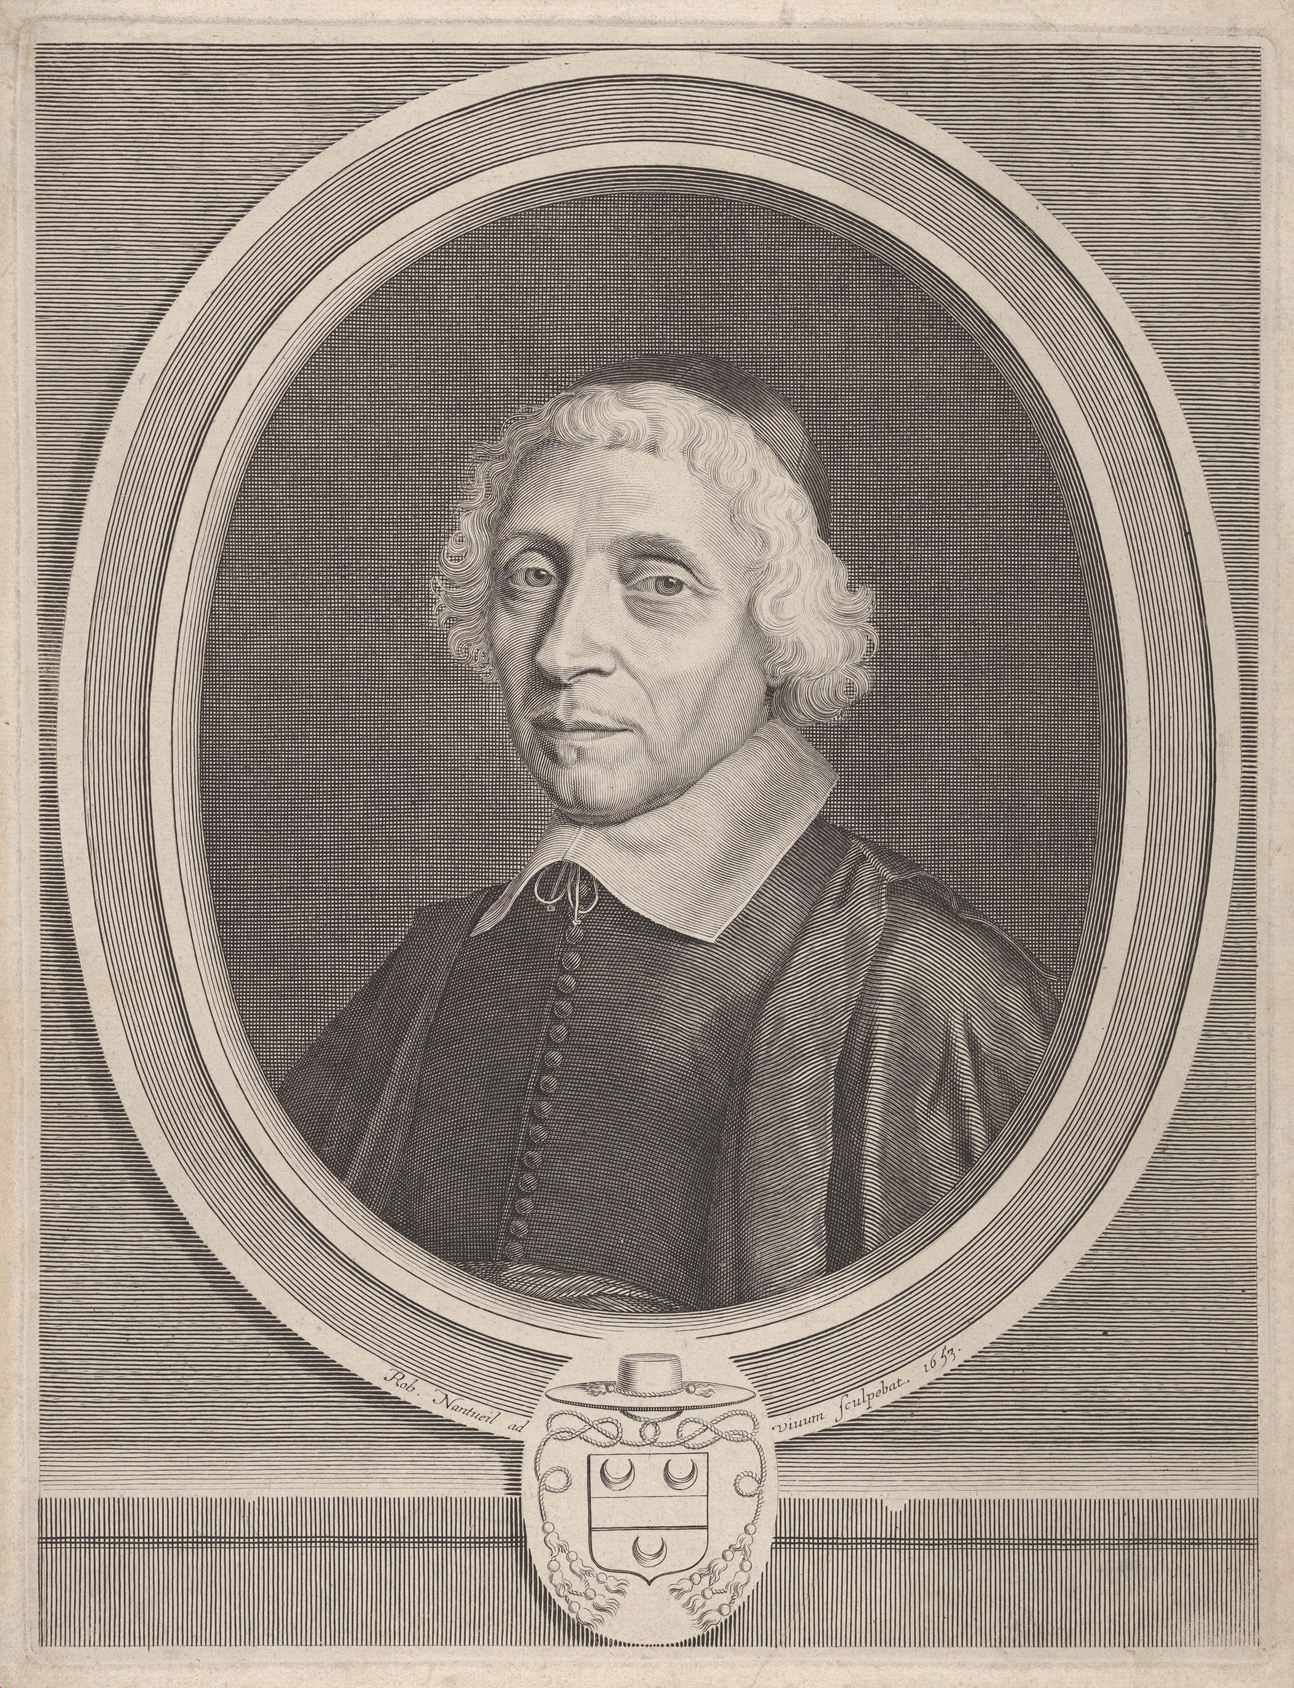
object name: print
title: Claude Thévenin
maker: robert nanteuil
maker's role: artist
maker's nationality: french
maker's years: 1623-1678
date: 1653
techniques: engraving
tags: men,portraits